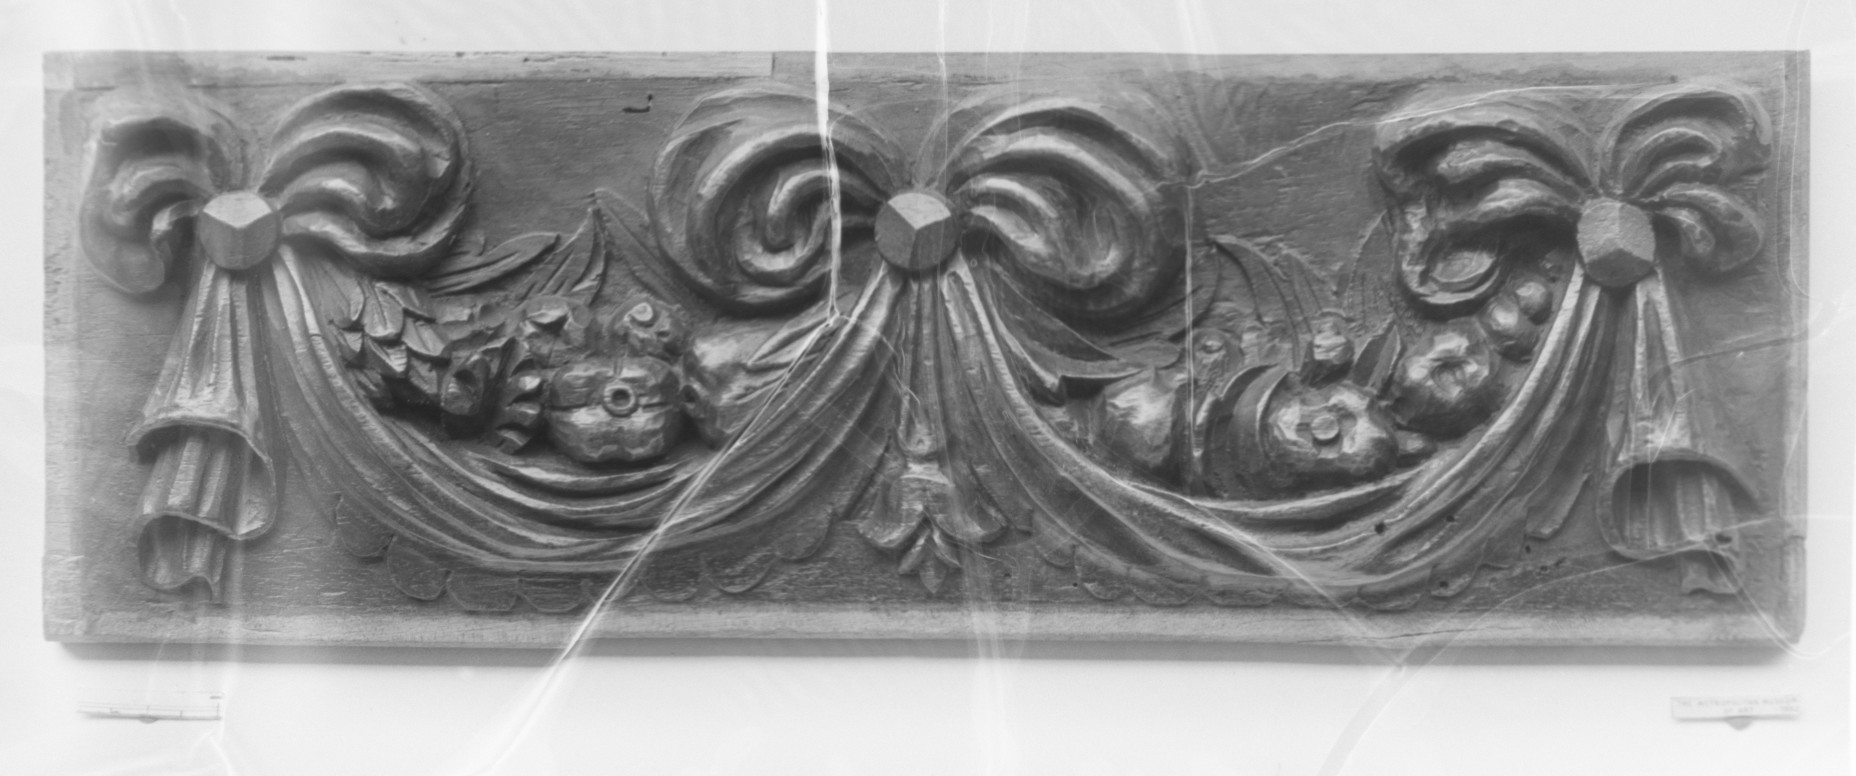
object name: panel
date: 1501-1600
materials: wood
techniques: carving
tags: fruit